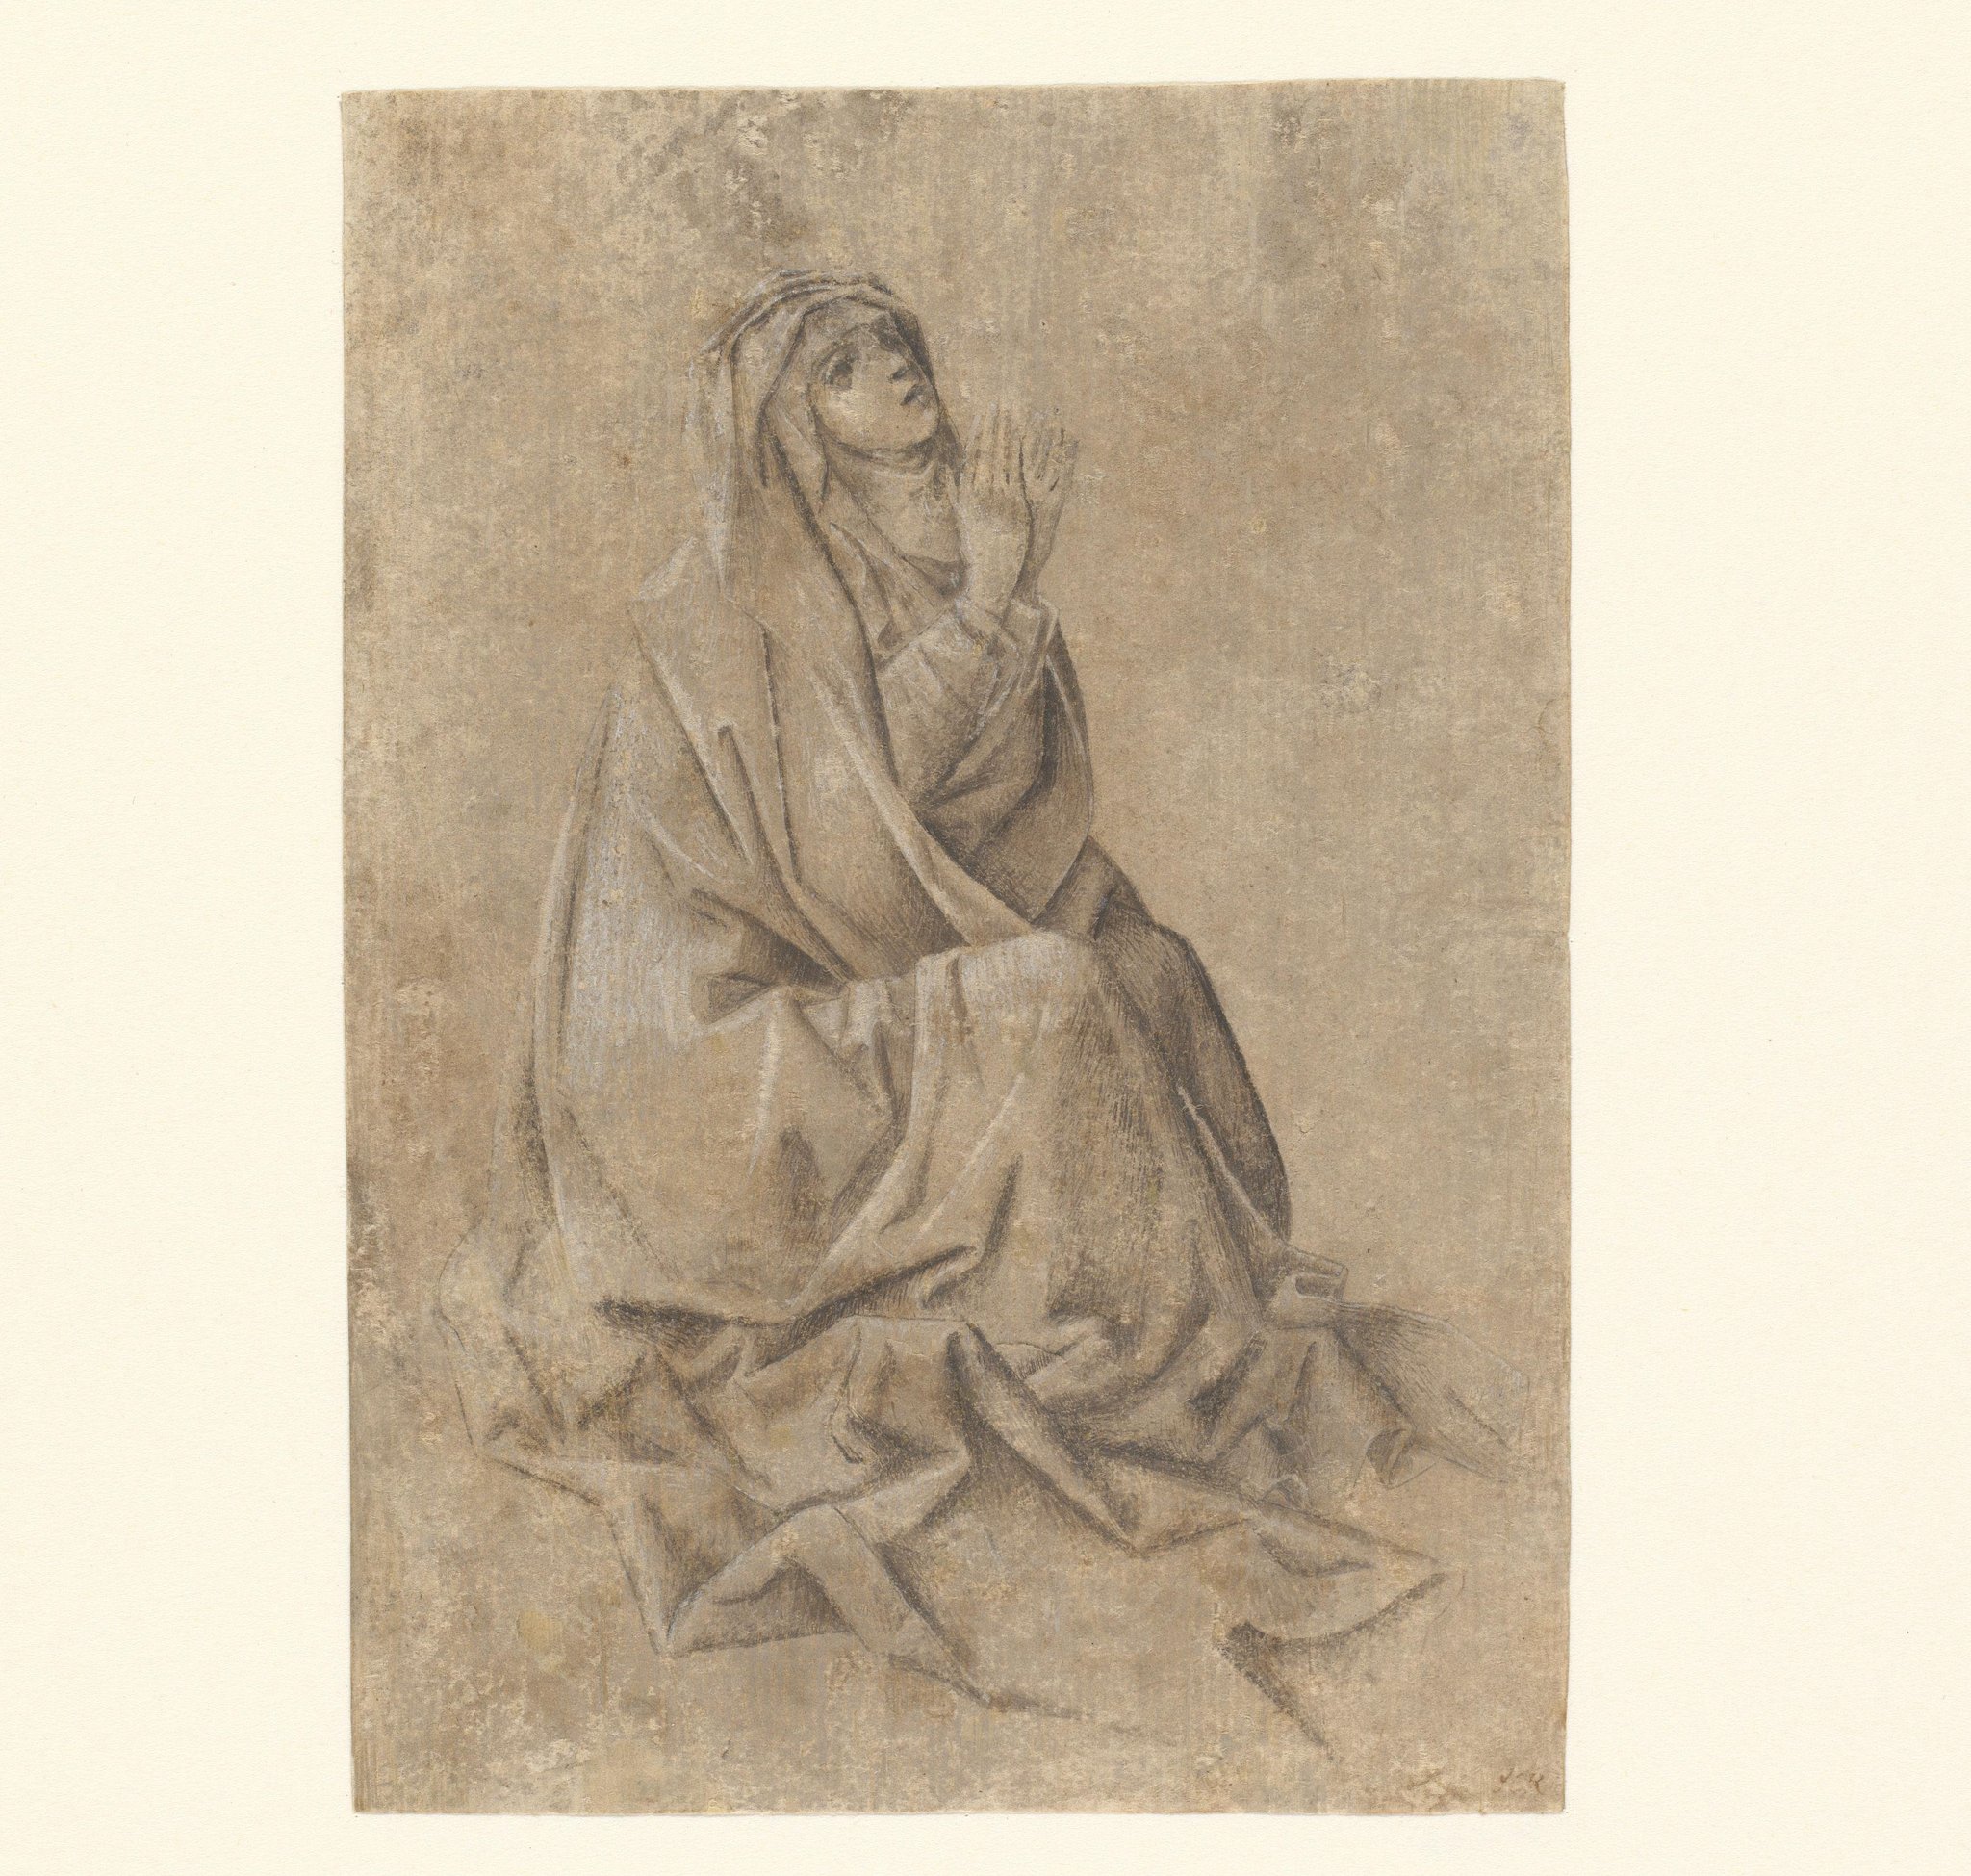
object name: drawing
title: Maria aan de voet van het kruis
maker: Anonymous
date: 1425-1440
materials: ink, paint, paper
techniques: brush, pen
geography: southern netherlands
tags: the virgin mary, the crucifixion of christ: christ's death on the cross; golgotha (matthew 27:45-58; mark 15:33-45; luke 23:44-52; john 19:25-38)